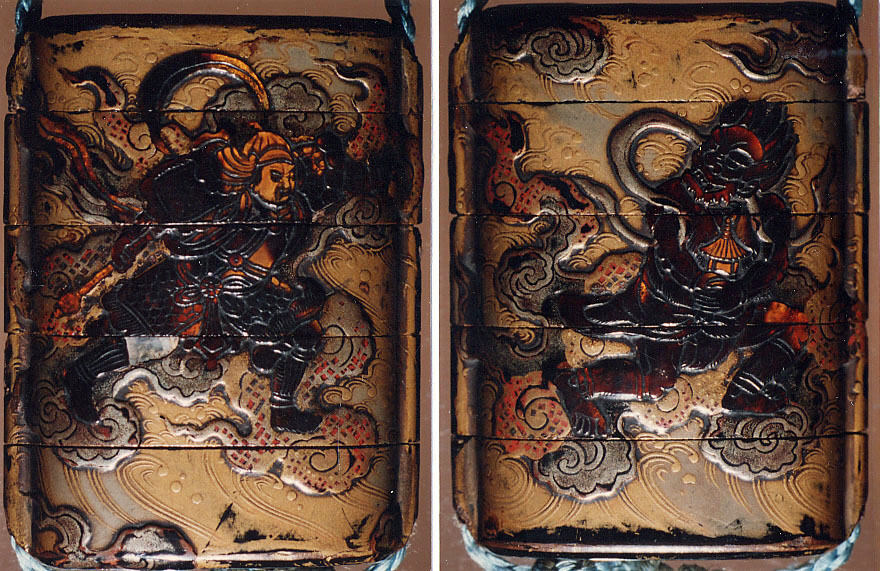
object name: inrō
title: Case (Inrō) with Design of Bishamon on Clouds Pursuing Demon (Oni) Holding Sacred Gem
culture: japanese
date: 1601-1700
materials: gold, lacquer, silver, shell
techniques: fundame, hiramakie, roiro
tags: demons